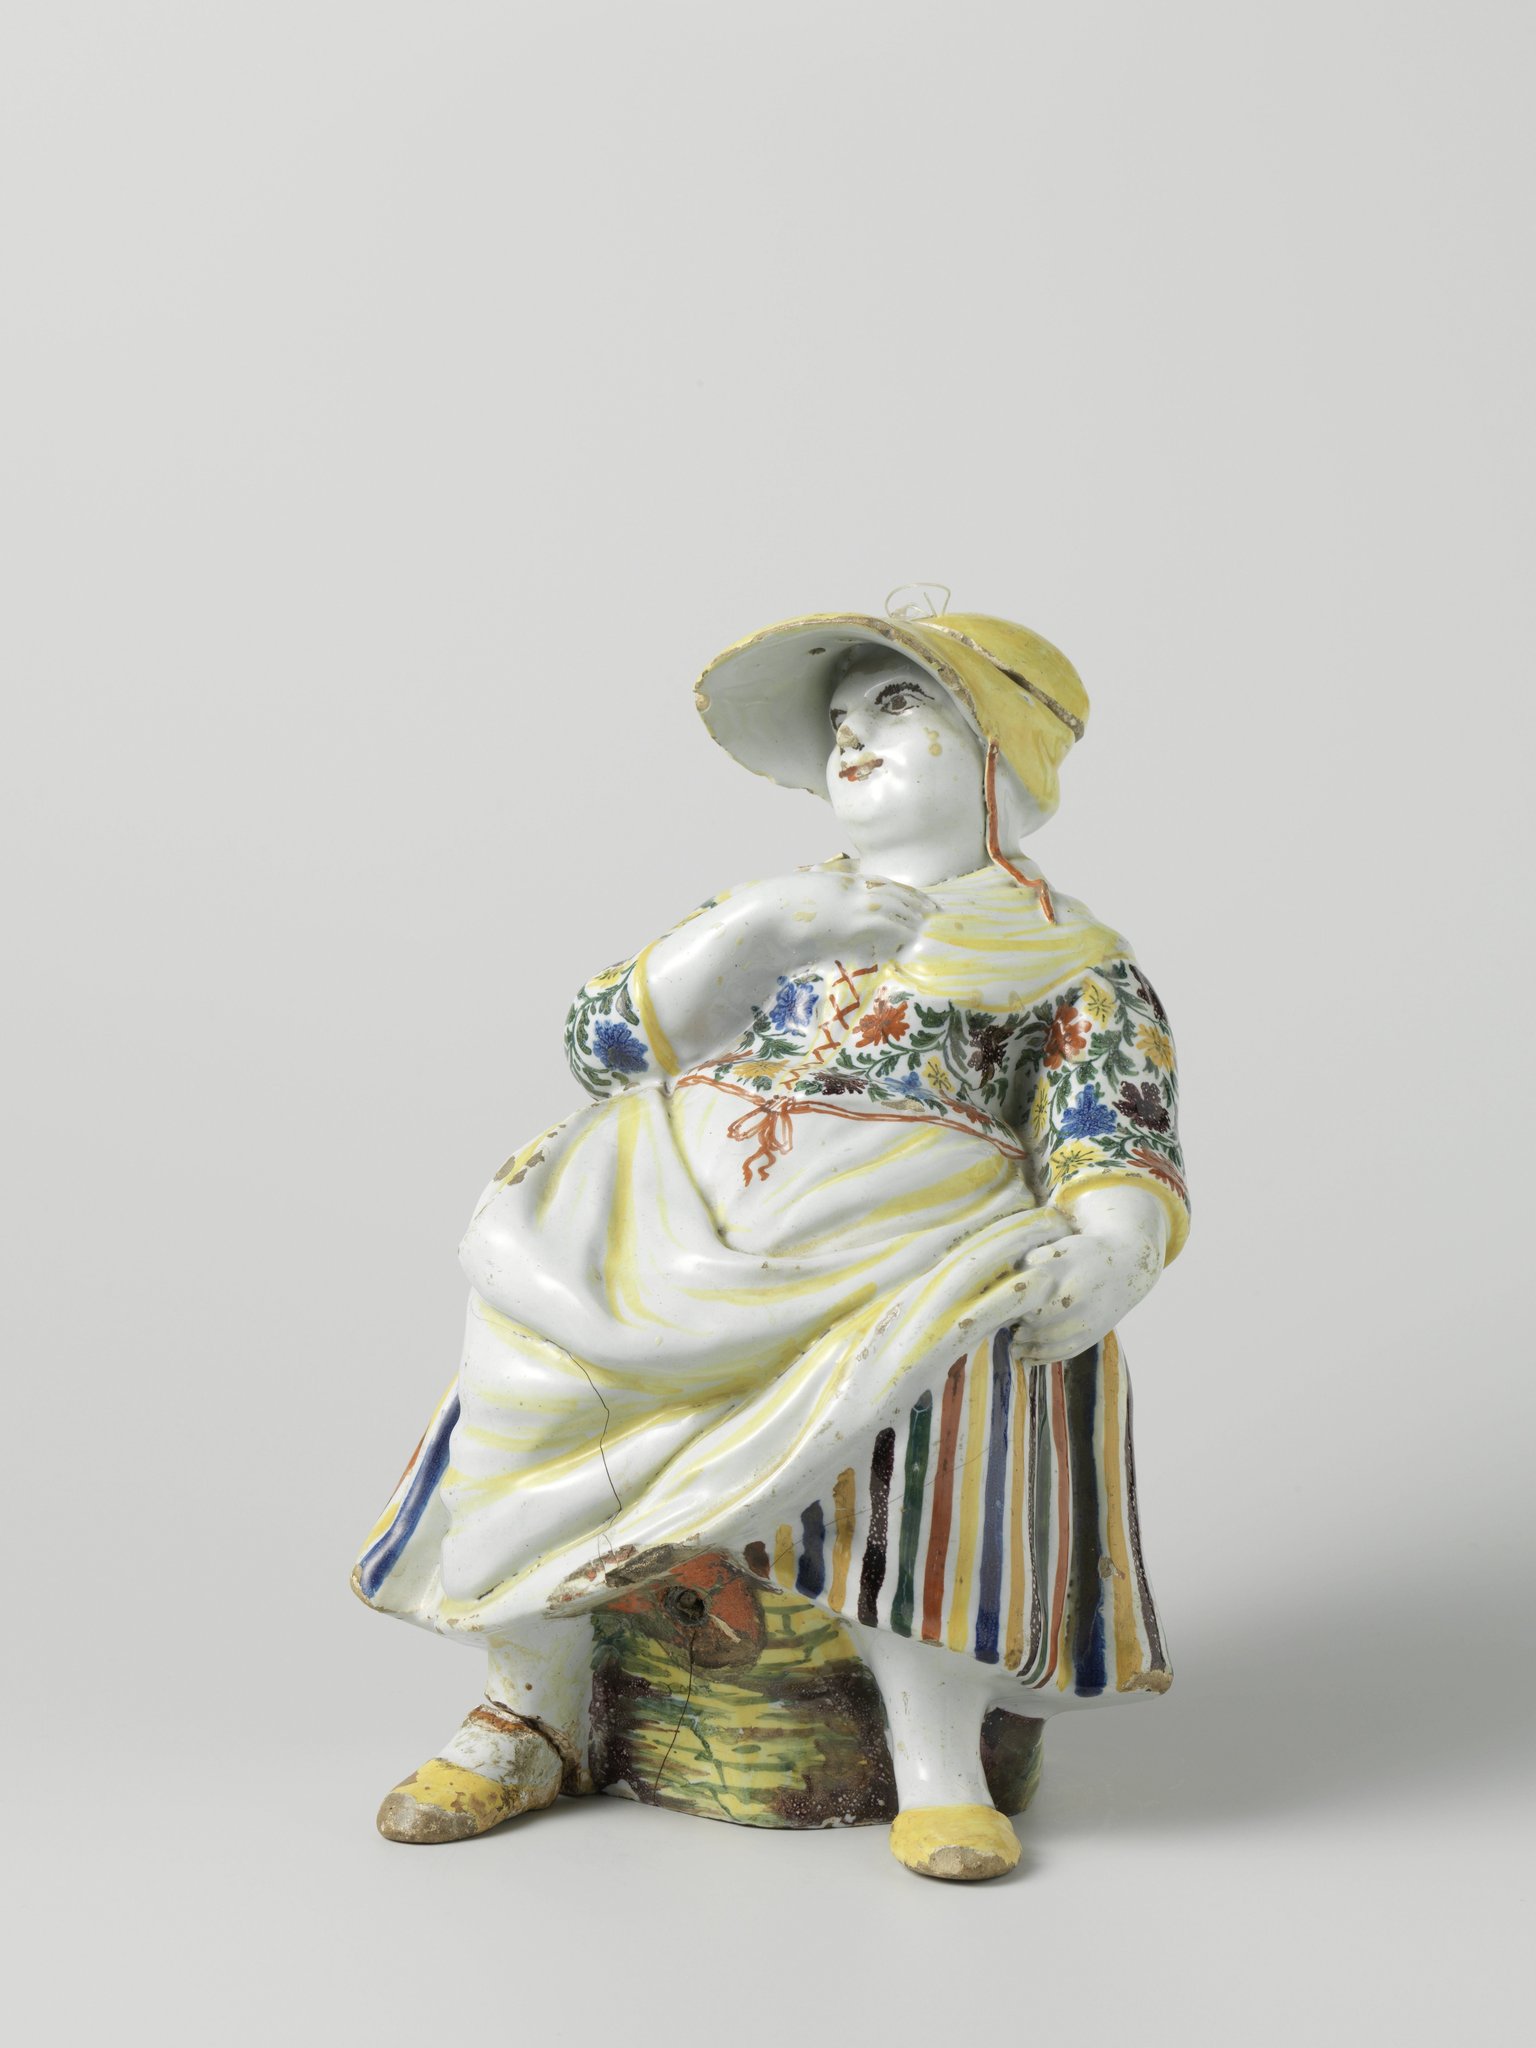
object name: chocolate pot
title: Kraantje van chocoladekan van faience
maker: Anonymous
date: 1775-1820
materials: metal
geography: delft